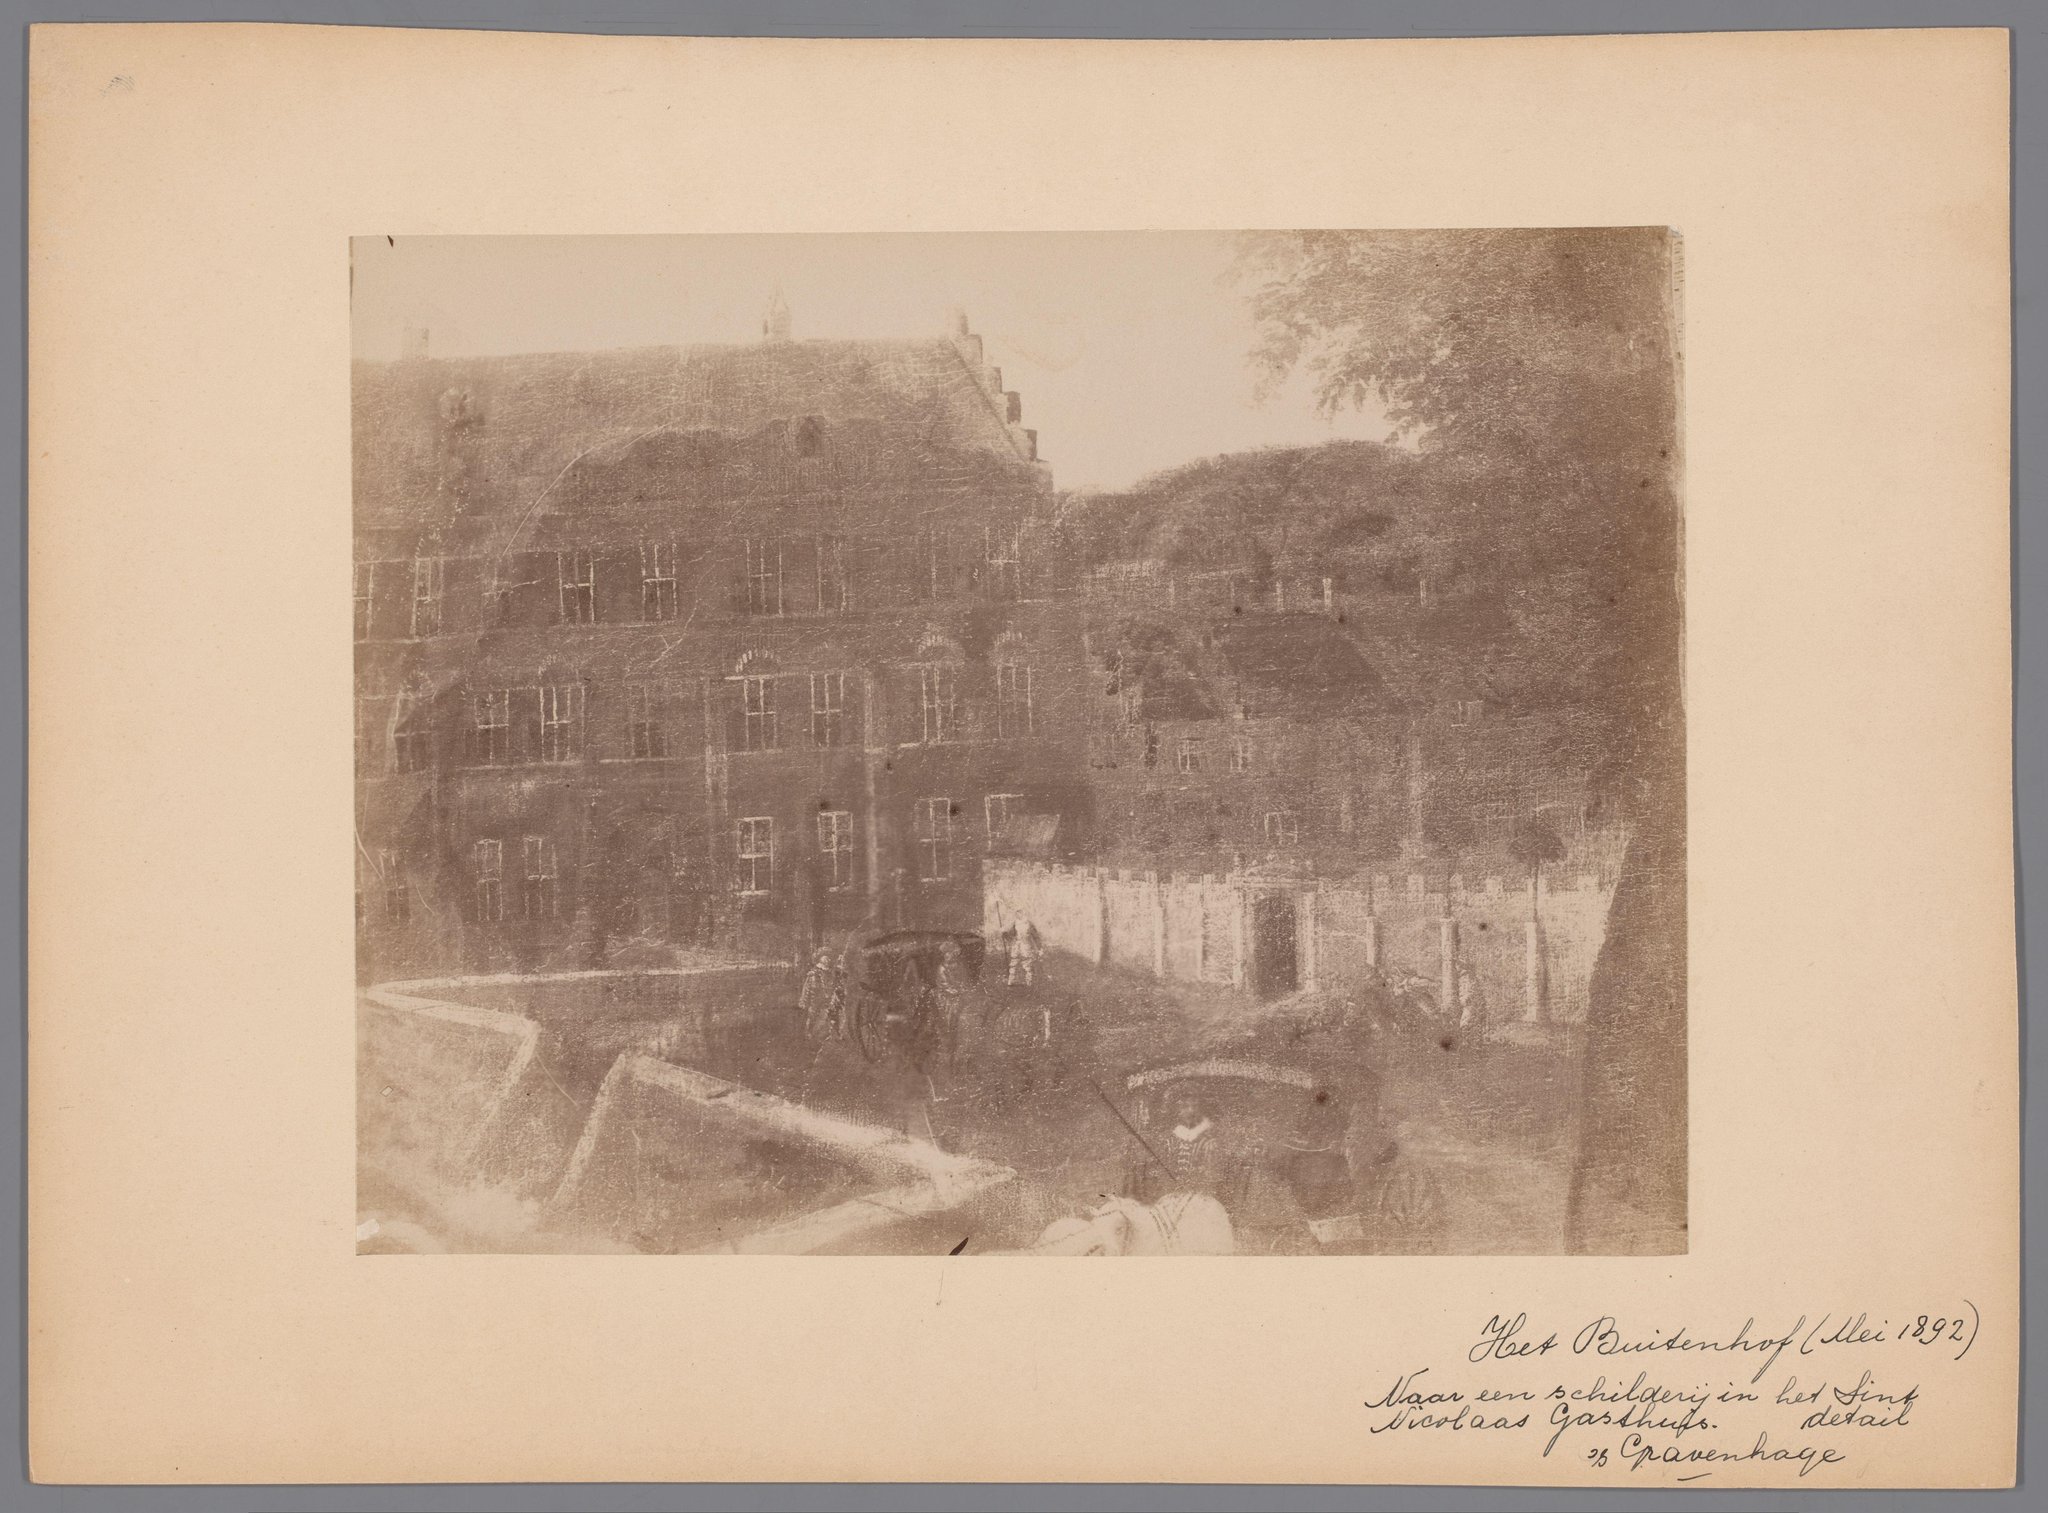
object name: photograph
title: Fotoreproductie van een schilderij van het Buitenhof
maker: anoniem (monumentenzorg)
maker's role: fotograaf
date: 1892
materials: cardboard, photographic support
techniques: albumen print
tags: national government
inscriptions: annotation: ‘Het hof te 's Gravenhage/ naar een schilderij in S. Nicolaas gasthuis aldaar (detail)/ Mei 1892’, annotation: ‘Het Buitenhof (Mei 1892)/ Naar een schilderij in het Sint Nicolaas gasthuis. detail/ 's Gravenhage’